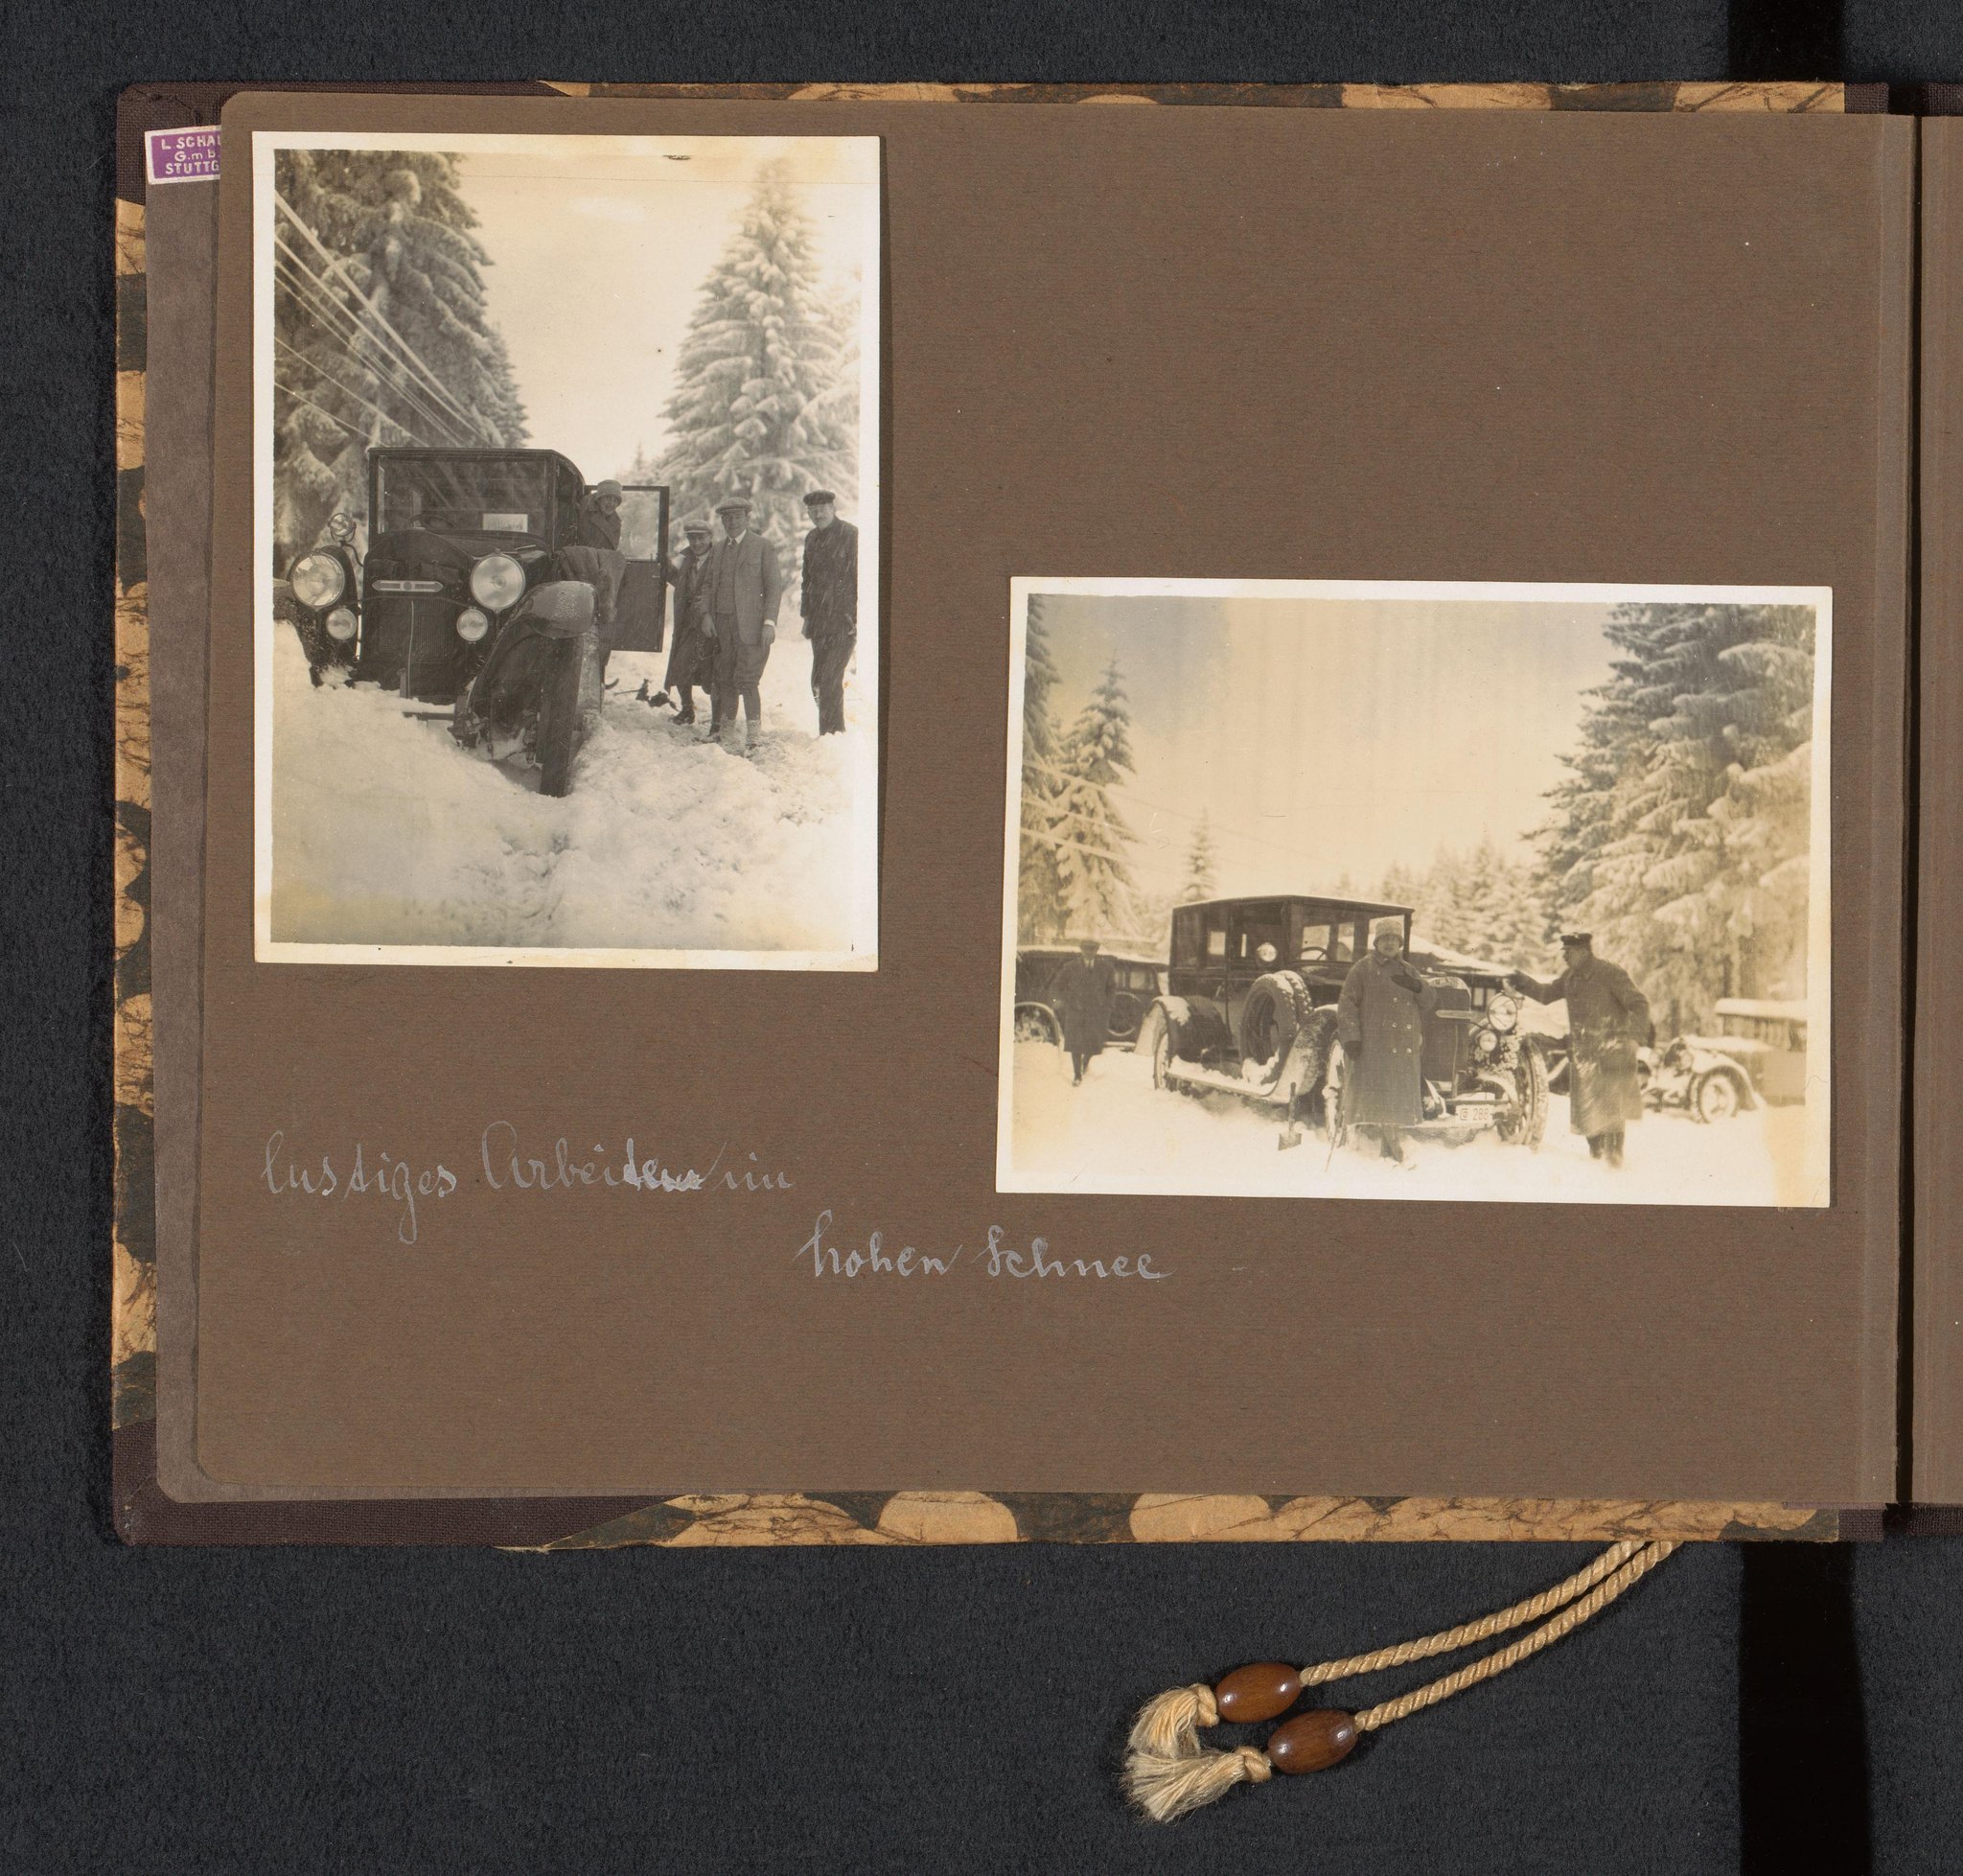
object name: photograph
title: Else Wachenheimer-Moos ingesneeuwd tijdens een autorit met haar echtgenoot Eugen Wachenheimer door Bulgarije, winter 1926-1927, Tschau Boria?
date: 1926-1927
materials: paper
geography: bulgaria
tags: else wachenheimer-moos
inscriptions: inscription: ‘lustiges Arbeiten in hohen Schnee’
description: Albumblad bevat twee foto's van Else Wachenheimer-Moos en onbekende mannen. Afkomstig uit album half formaat, kartonomslag met koordbinding en lichte veelvormige vormen op voorzijde.